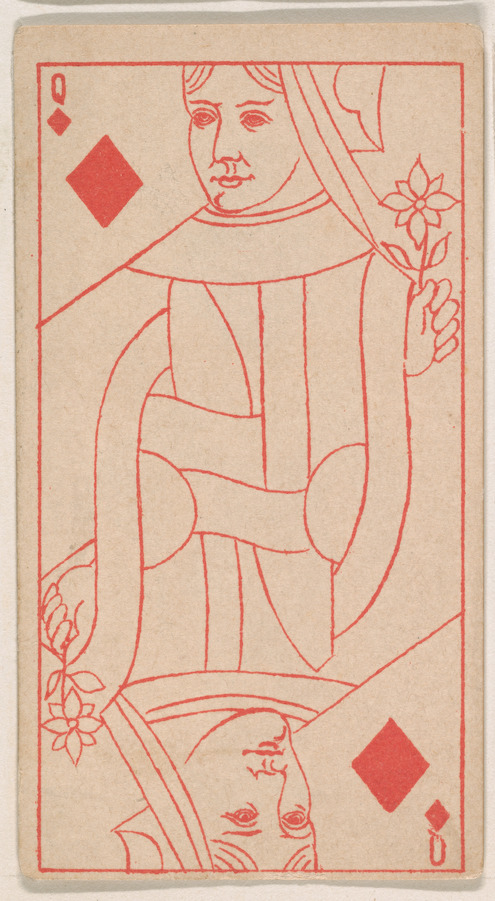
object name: print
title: Queen of Diamonds, from the Transparent Playing Cards series (N220) issued by Kinney Bros.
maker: kinney brothers tobacco company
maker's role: publisher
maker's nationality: american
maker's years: 1869-2011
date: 1888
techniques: color lithograph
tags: queens,playing cards